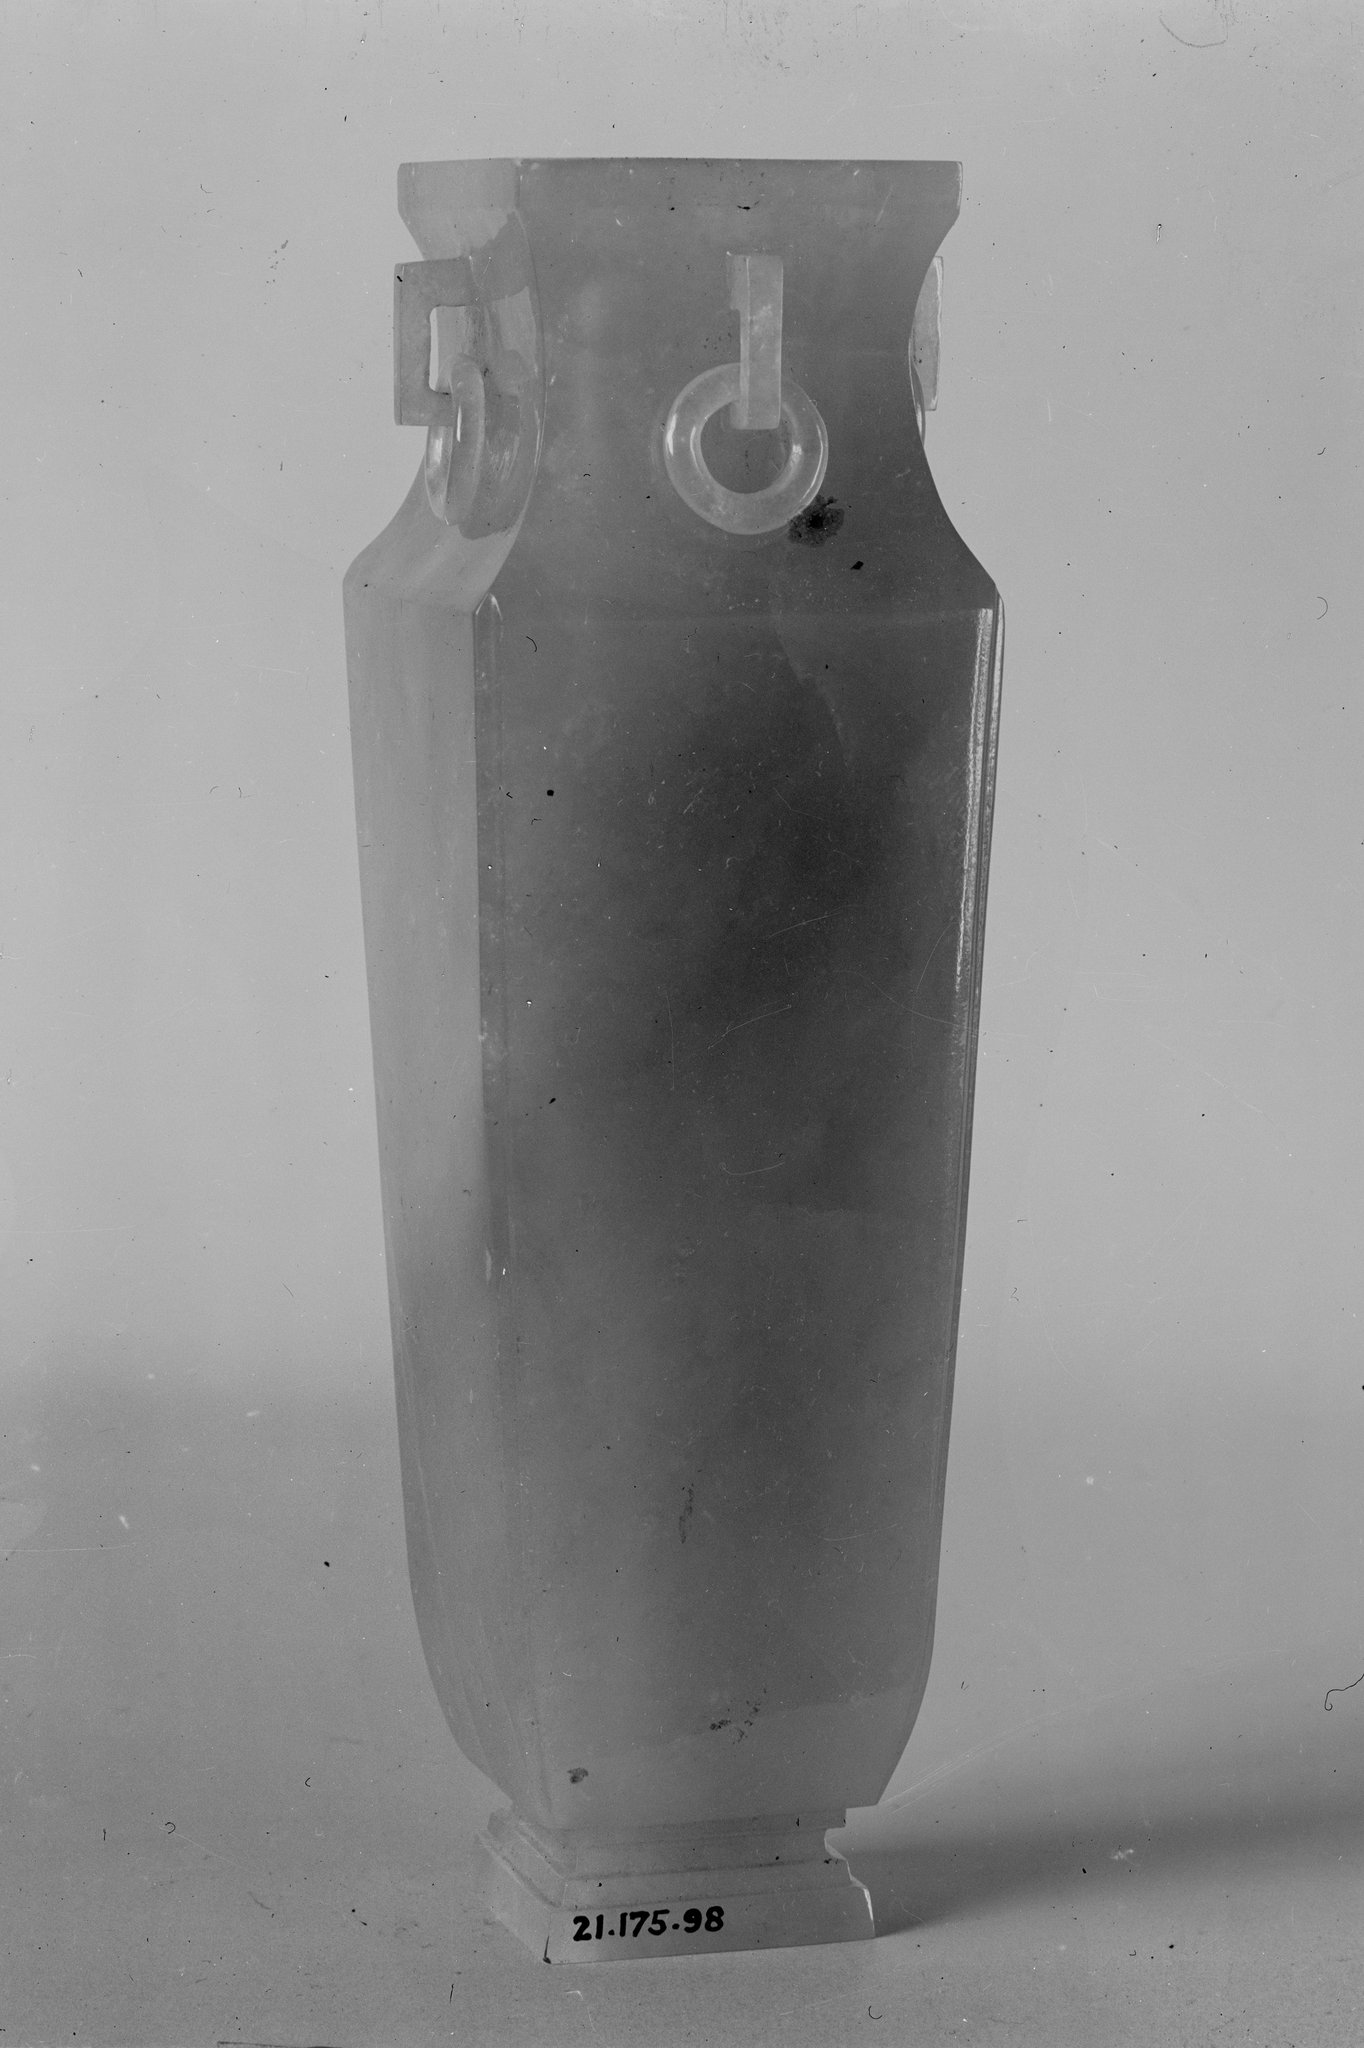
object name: vase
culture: chinese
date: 1736-1795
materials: jade